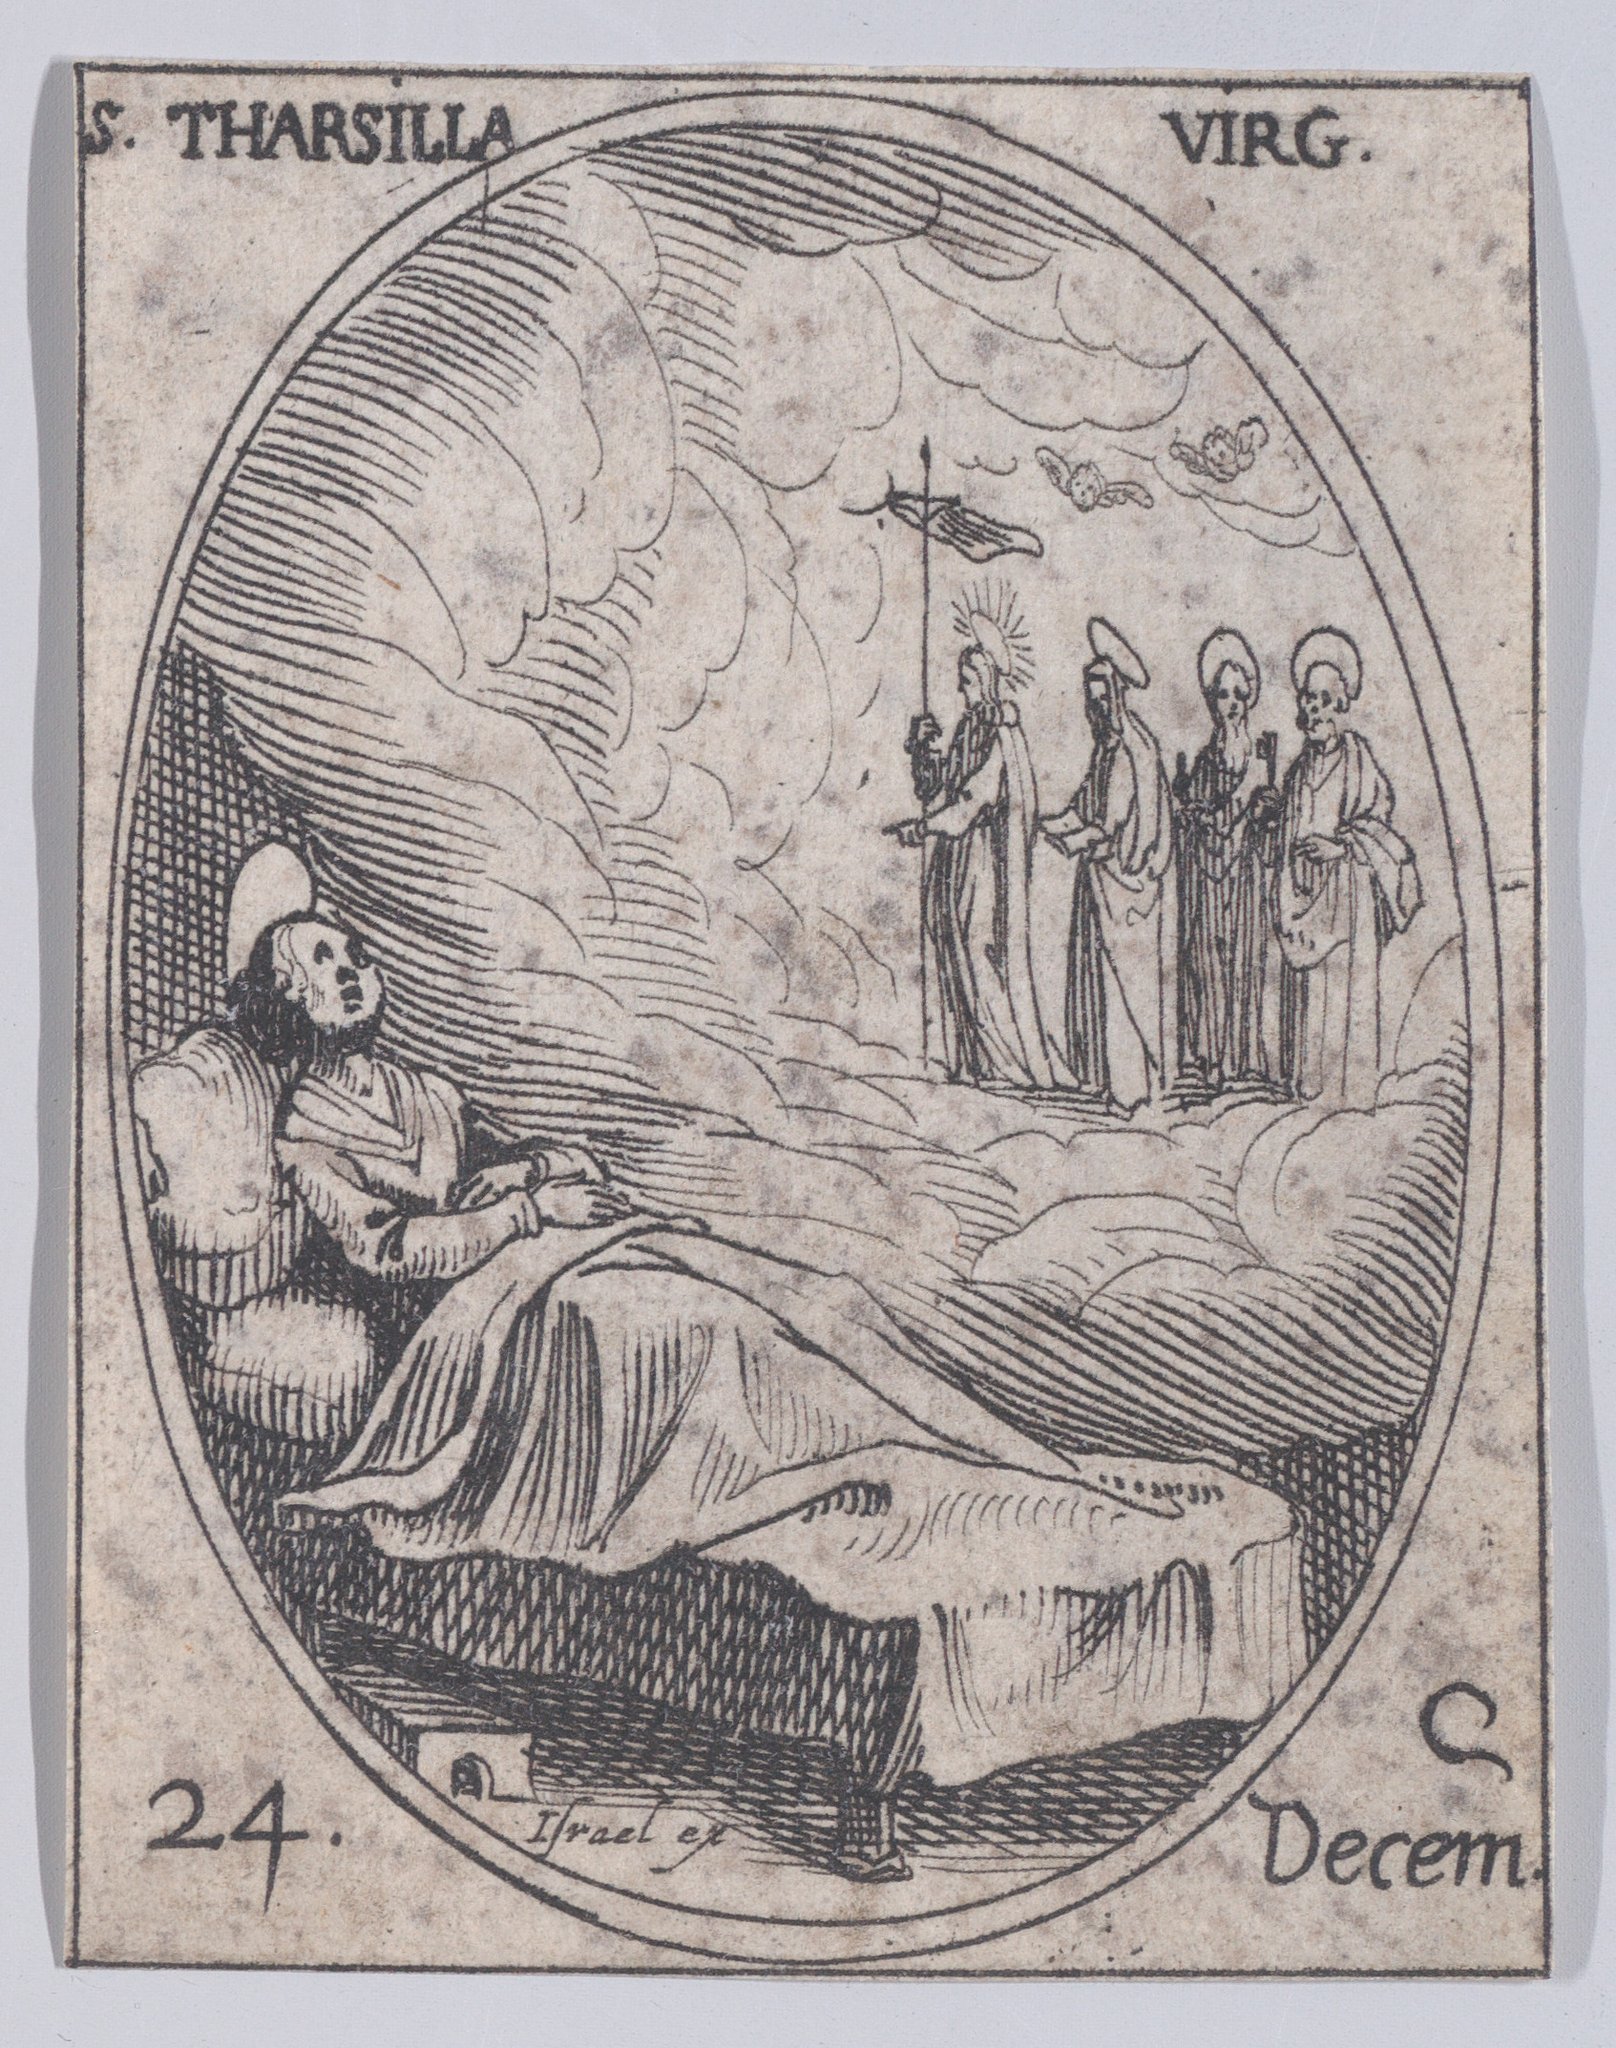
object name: print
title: Ste. Tarsille, vierge (St. Tarsilla, Virgin), December 24th, from "Les Images De Tous Les Saincts et Saintes de L'Année" (Images of All of the Saints and Religious Events of the Year)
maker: jacques callot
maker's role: artist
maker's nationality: french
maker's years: 1592-1635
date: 1636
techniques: etching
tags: women,saints